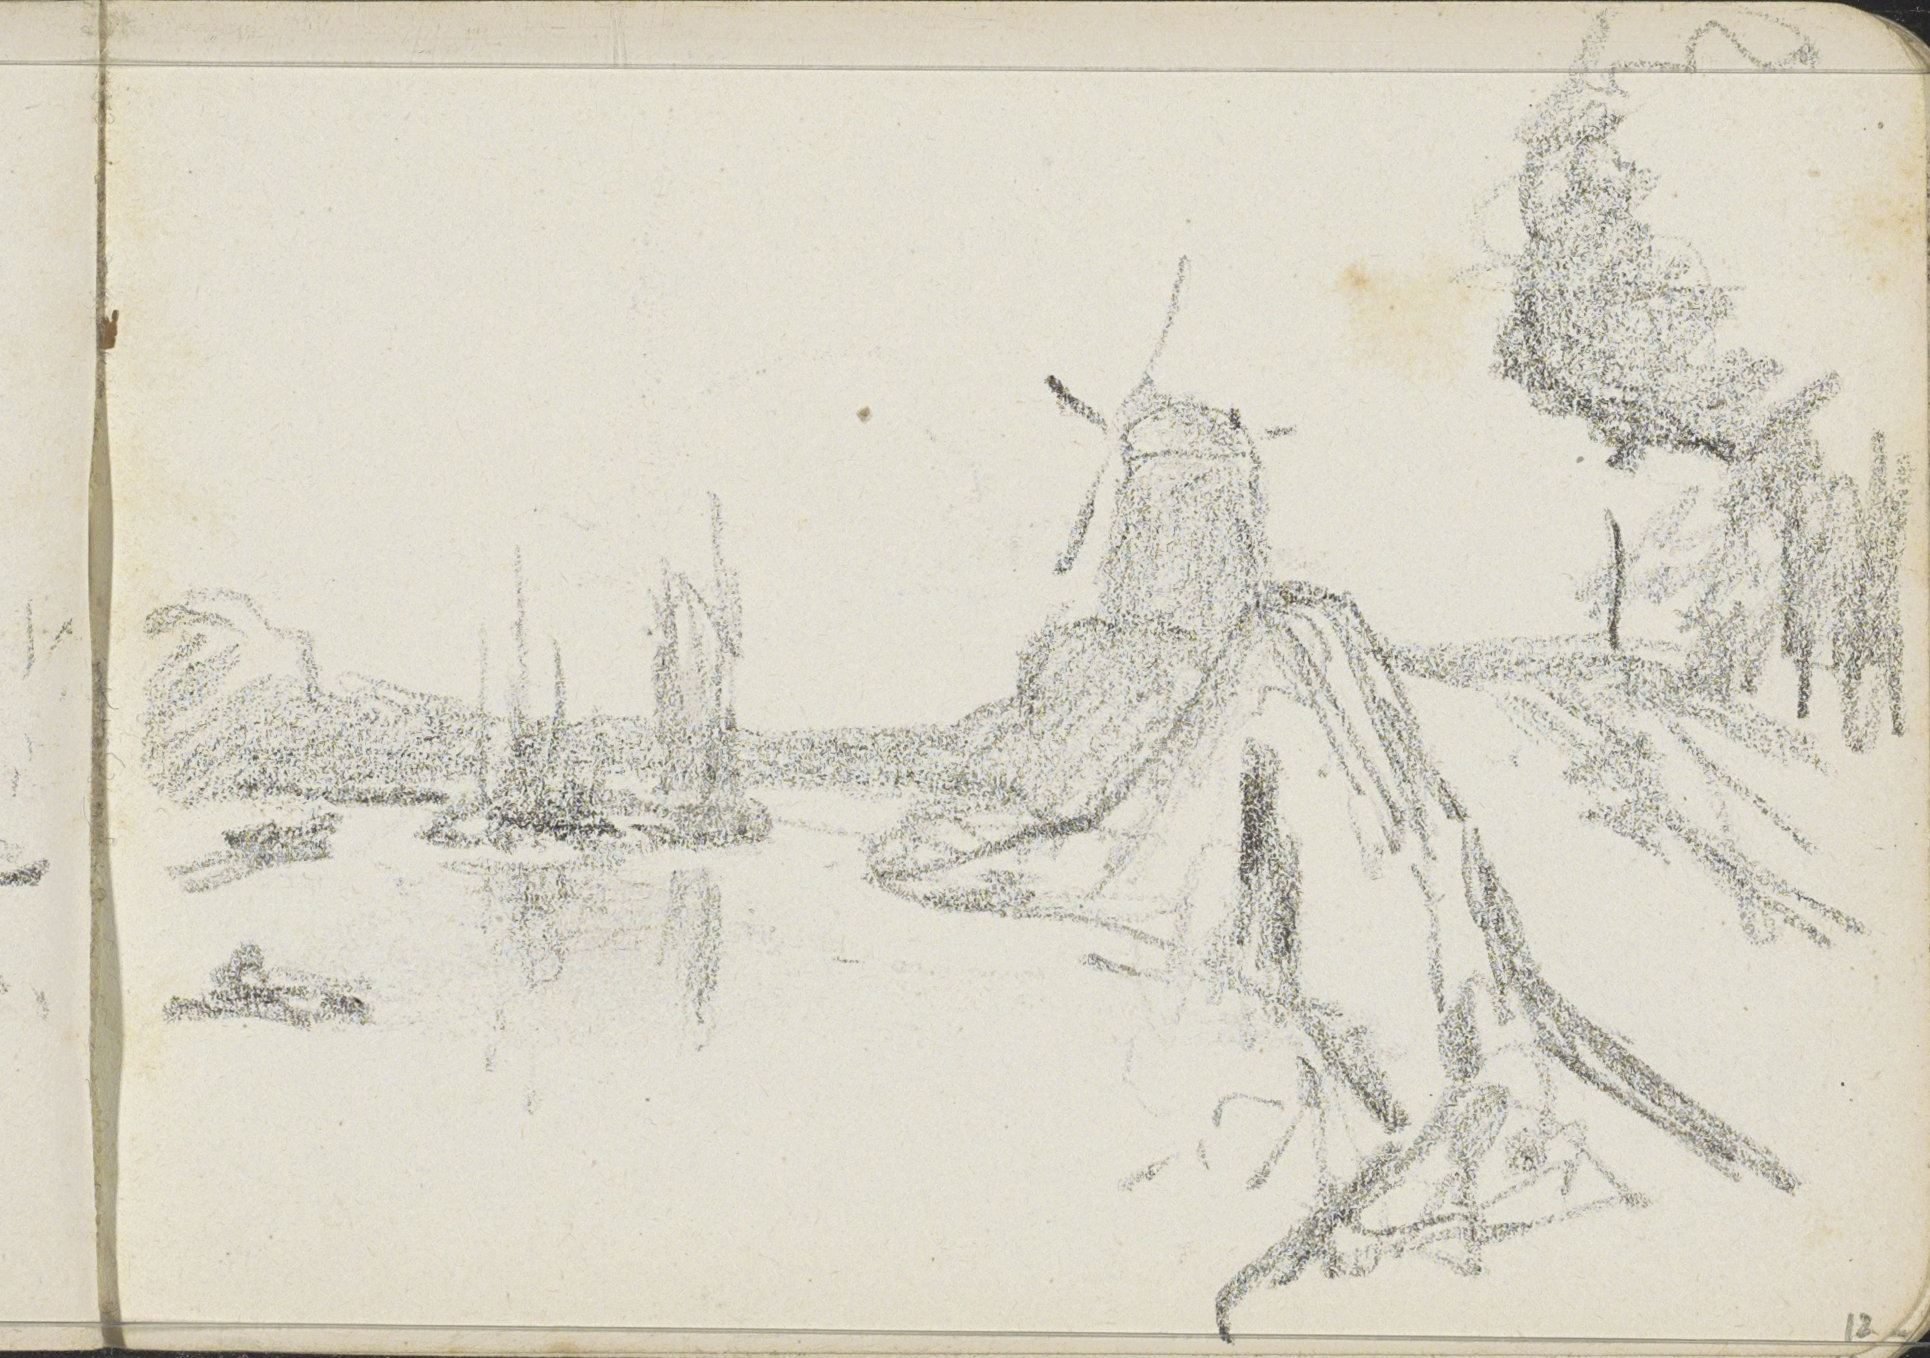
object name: sketchbook leaf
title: Pad en molen aan een vaart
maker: willem cornelis rip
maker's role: draughtsman, painter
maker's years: 1856-1922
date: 1907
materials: chalk, paper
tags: landscapes with waters, waterscapes, seascapes (in the temperate zone), road, path, windmill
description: Blad 12 recto uit een schetsboek met 41 bladen.